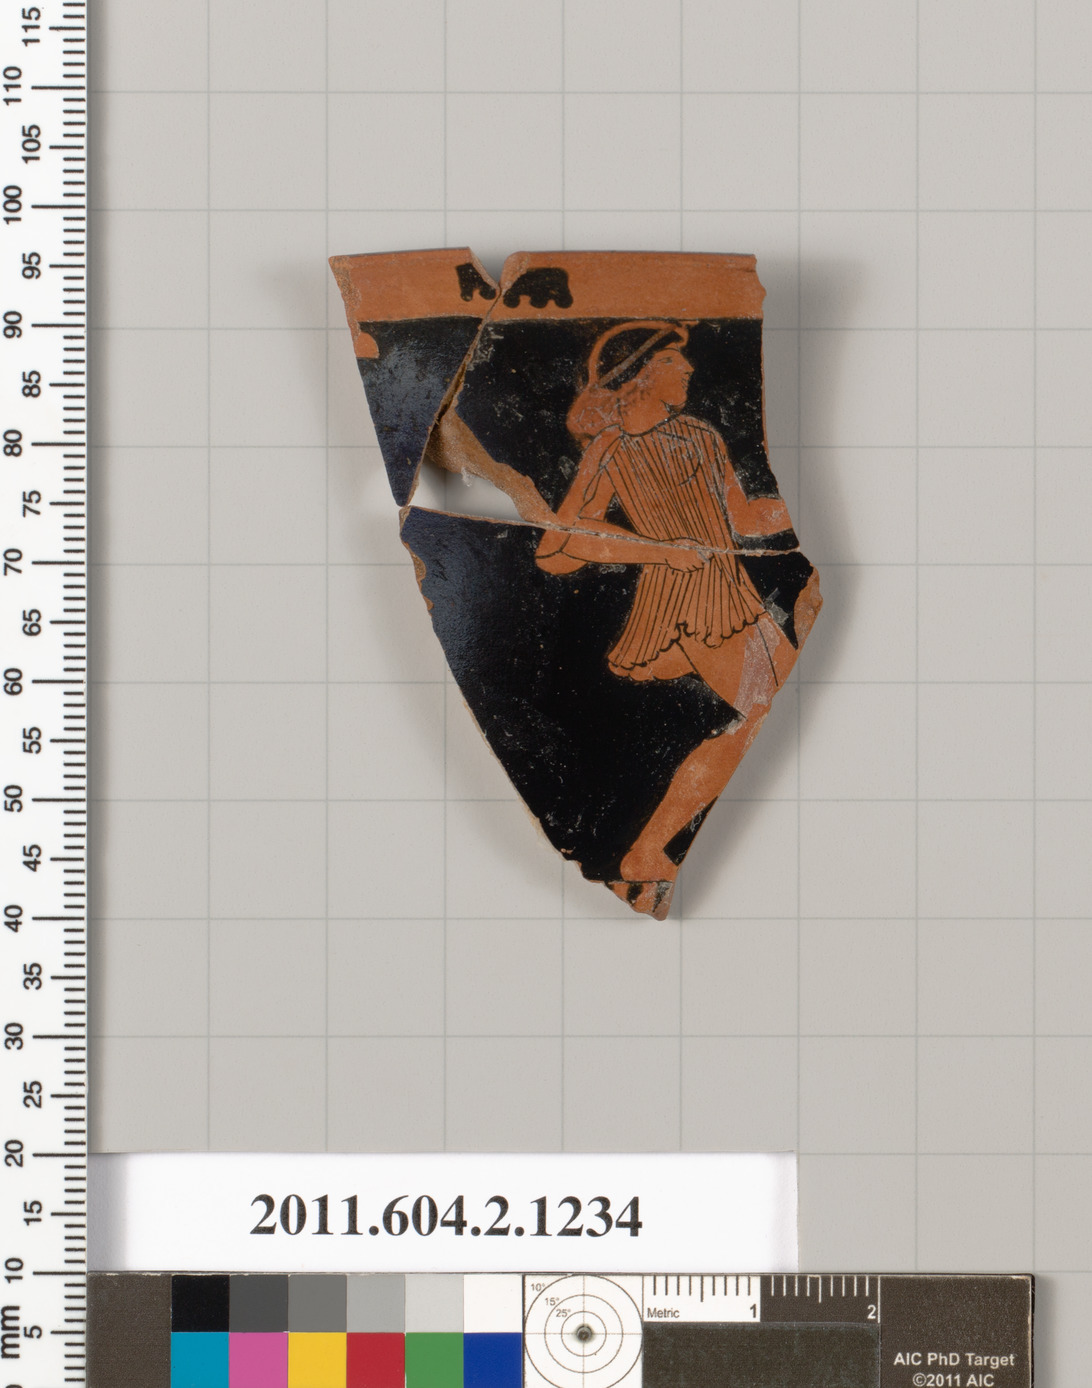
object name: rhyton fragment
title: Terracotta rhyton (vase for libations or drinking)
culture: greek, attic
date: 475-451 BCE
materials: terracotta